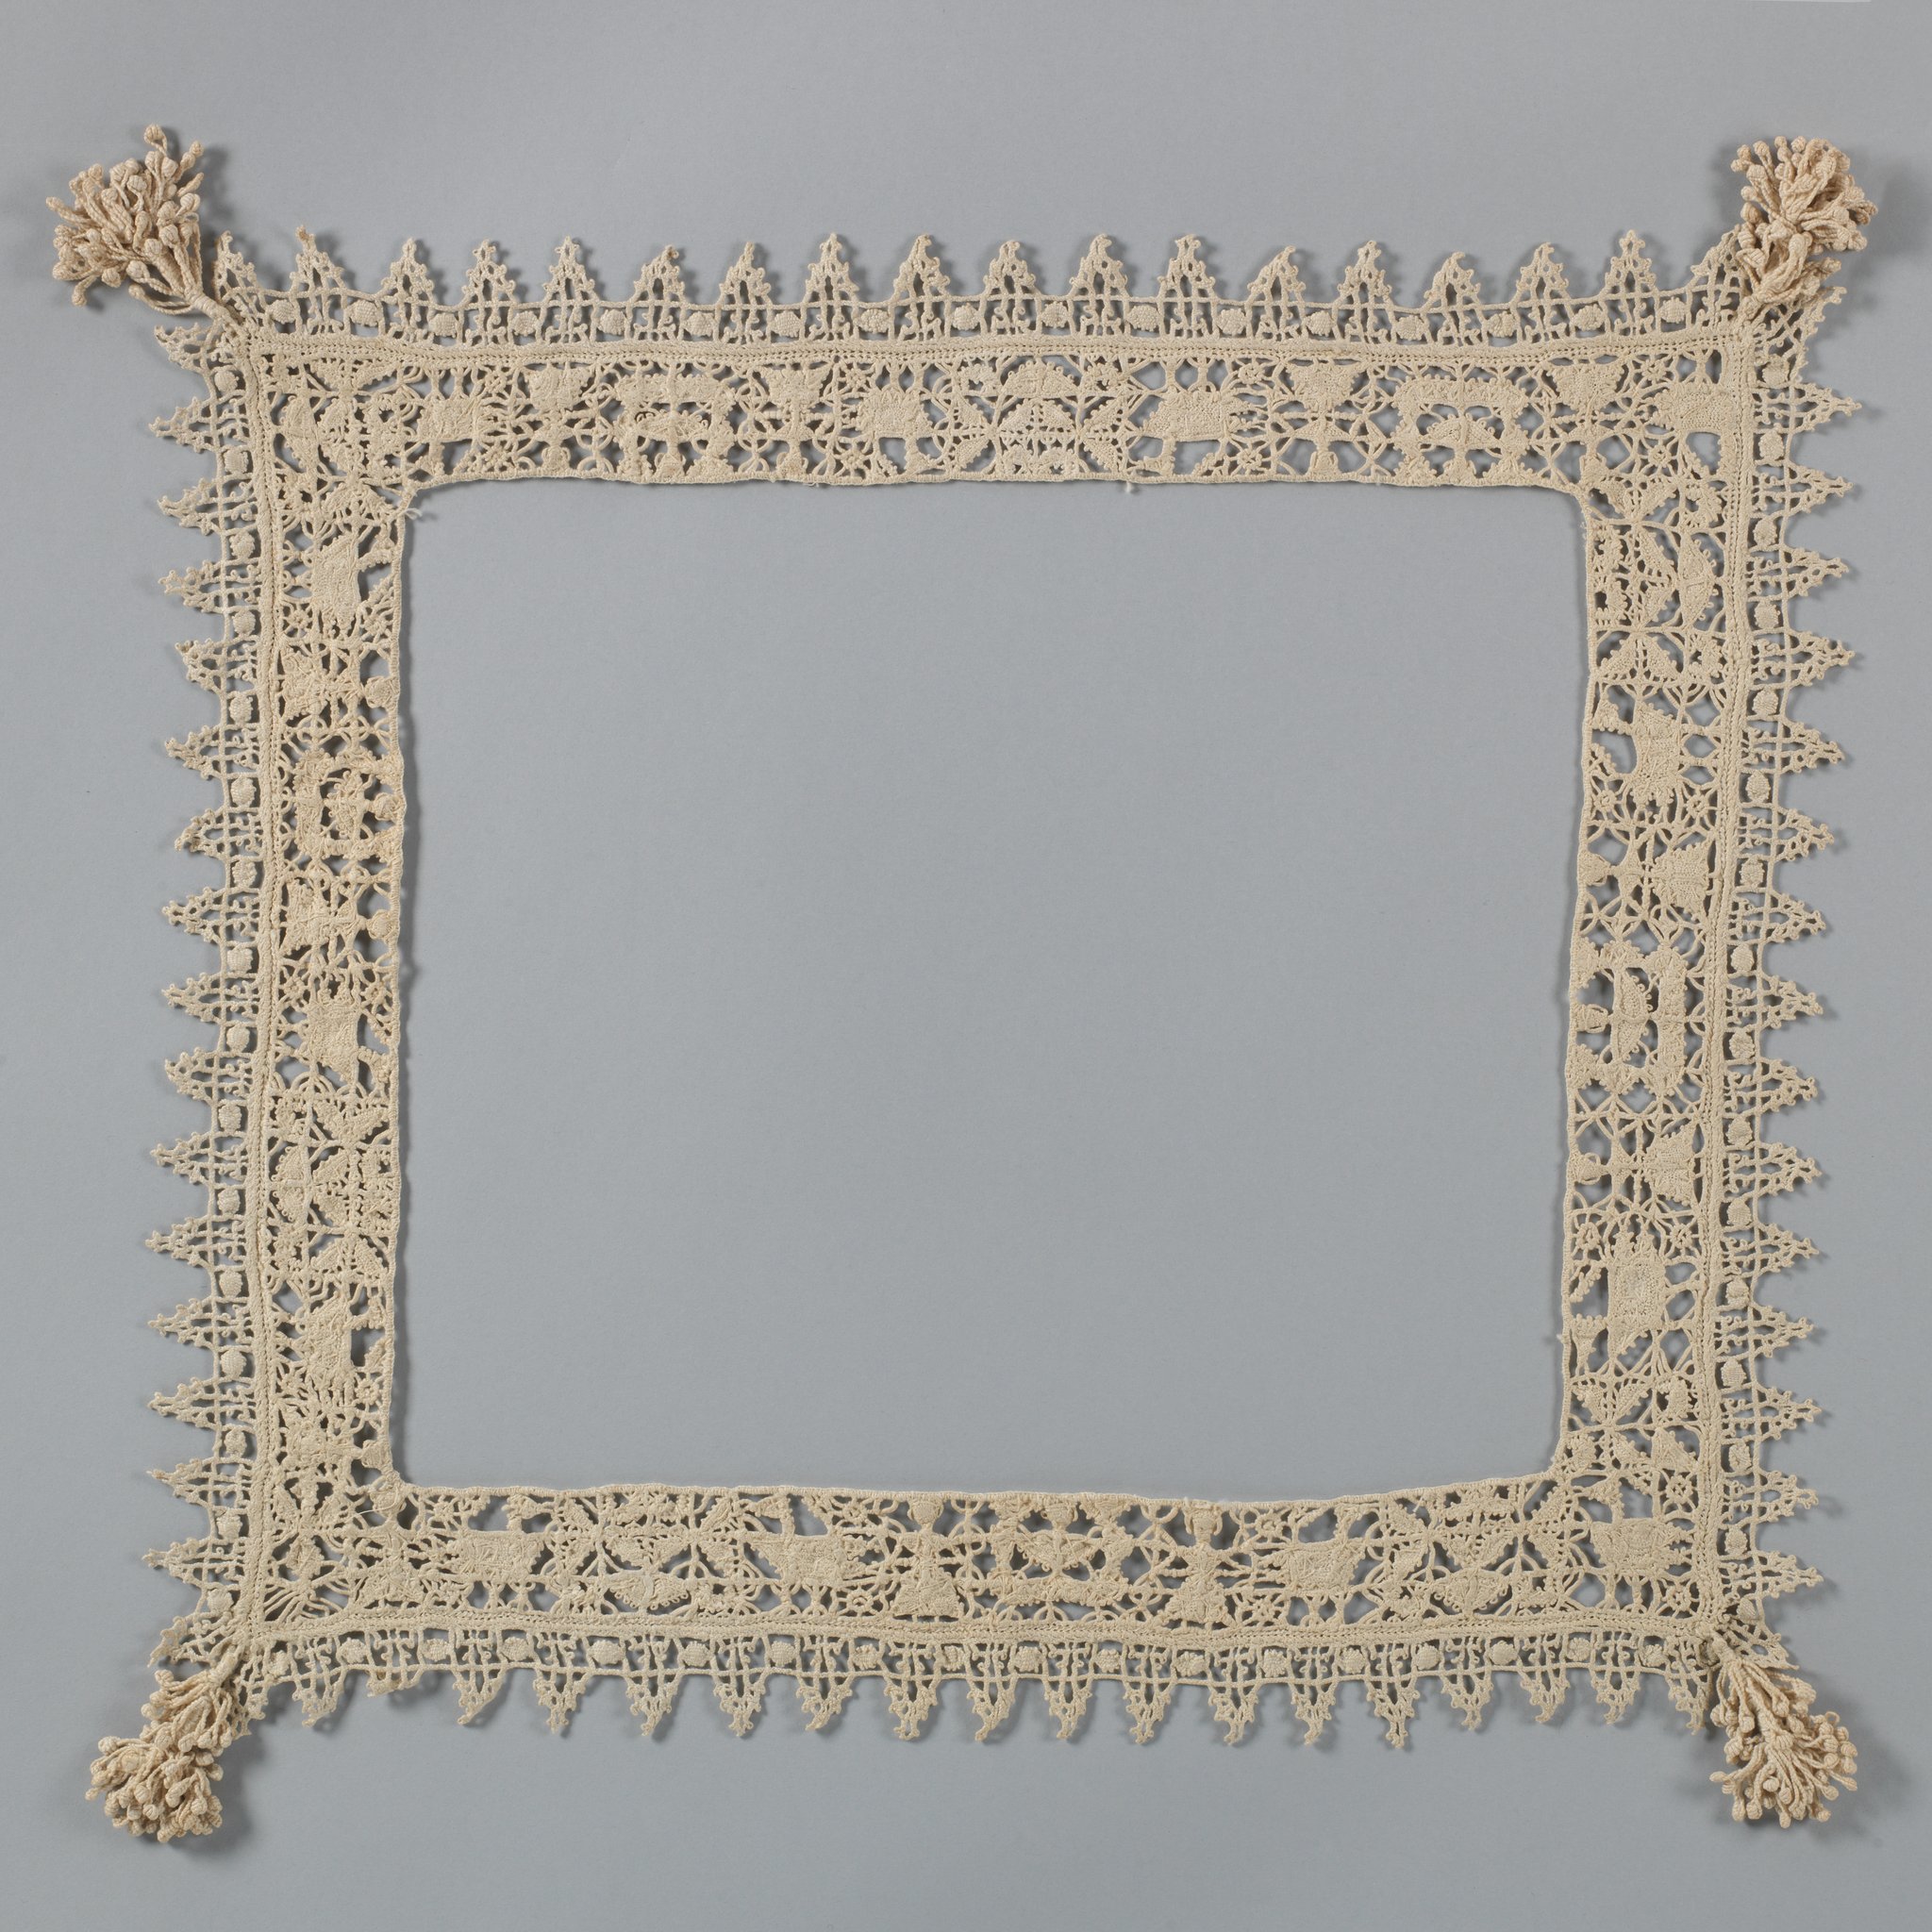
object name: border for cover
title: Border for a cover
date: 1501-1600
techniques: lace